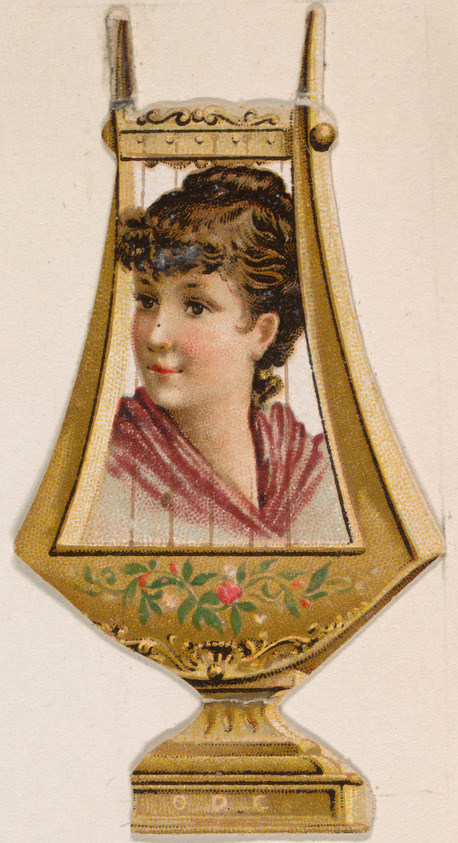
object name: print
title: Lyre, from the Novelties series (N228, Type 3) issued by Kinney Bros.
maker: kinney brothers tobacco company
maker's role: publisher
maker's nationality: american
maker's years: 1869-2011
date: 1889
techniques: color lithograph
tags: musical instruments,women